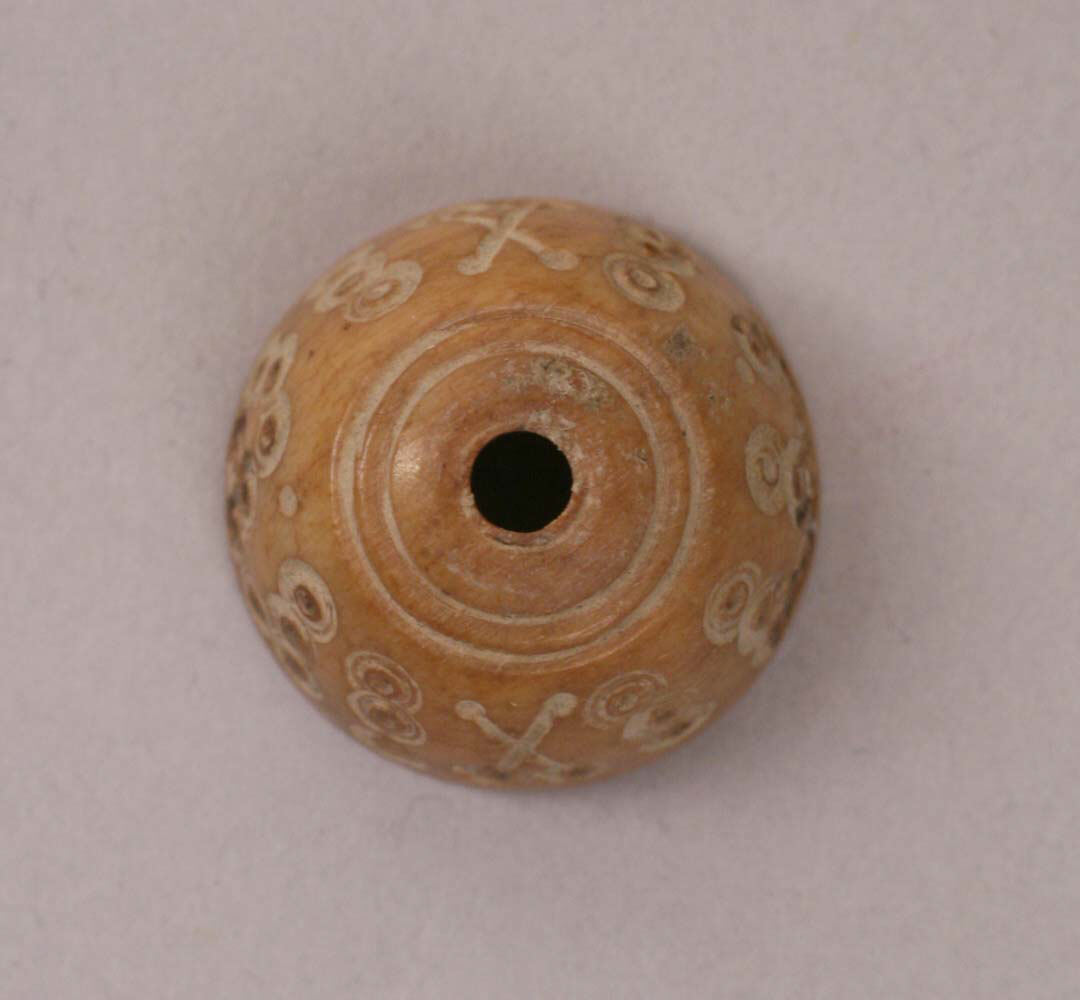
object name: button or bead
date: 801-1000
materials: bone, paint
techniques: incising, inlay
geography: iran